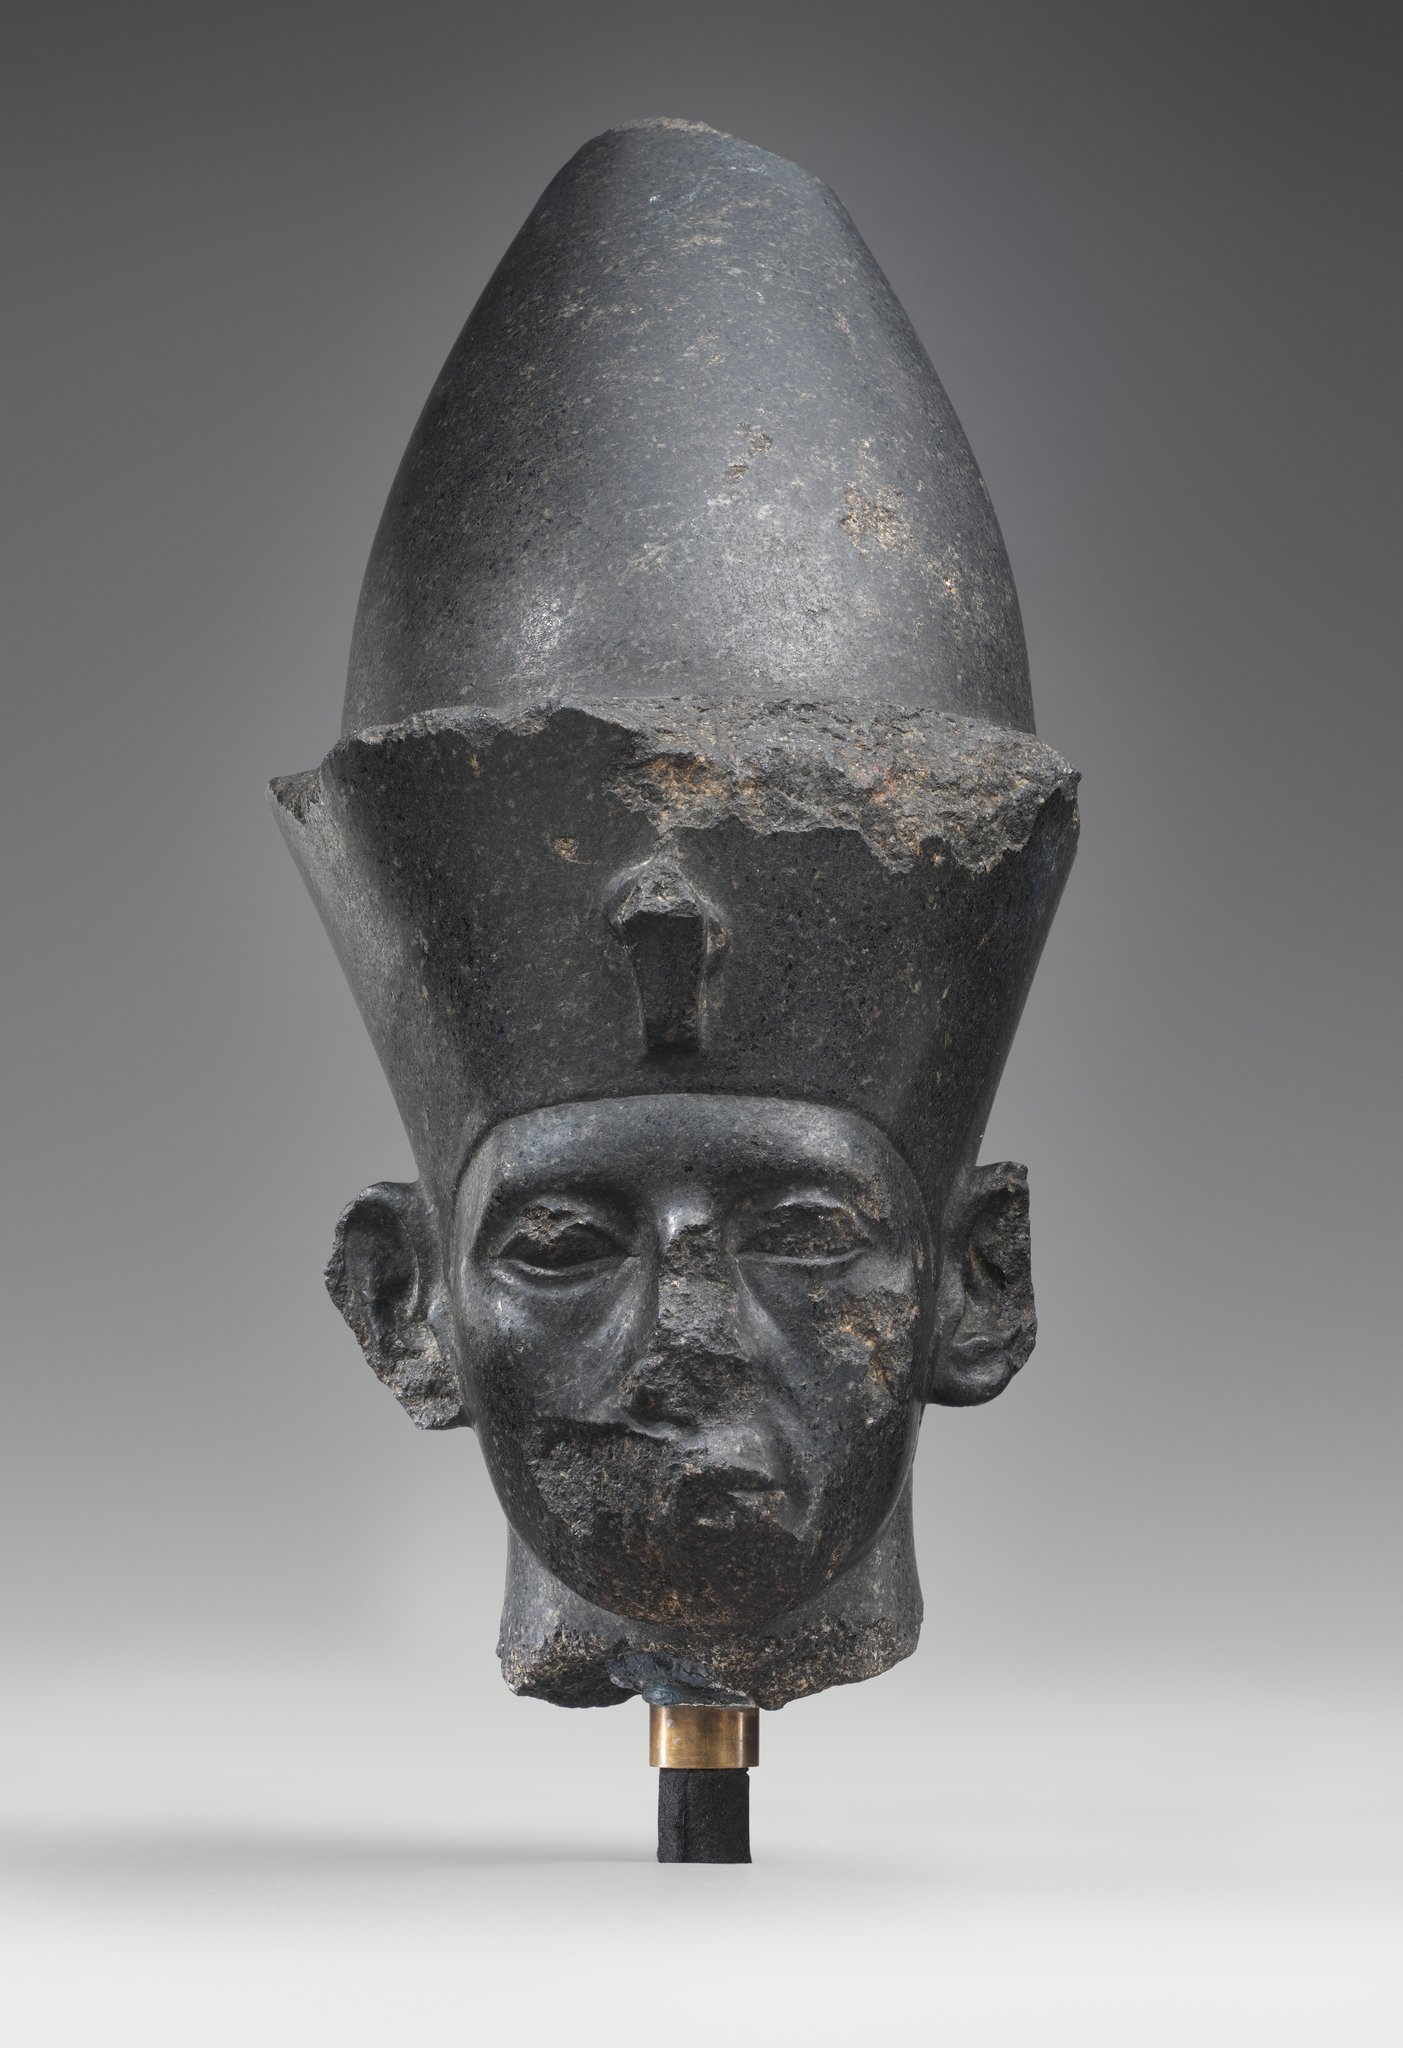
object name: head, amenemhat iii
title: Head of King Amenemhat III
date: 1859-1813 BCE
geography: egypt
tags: kings,heads,mk-kings